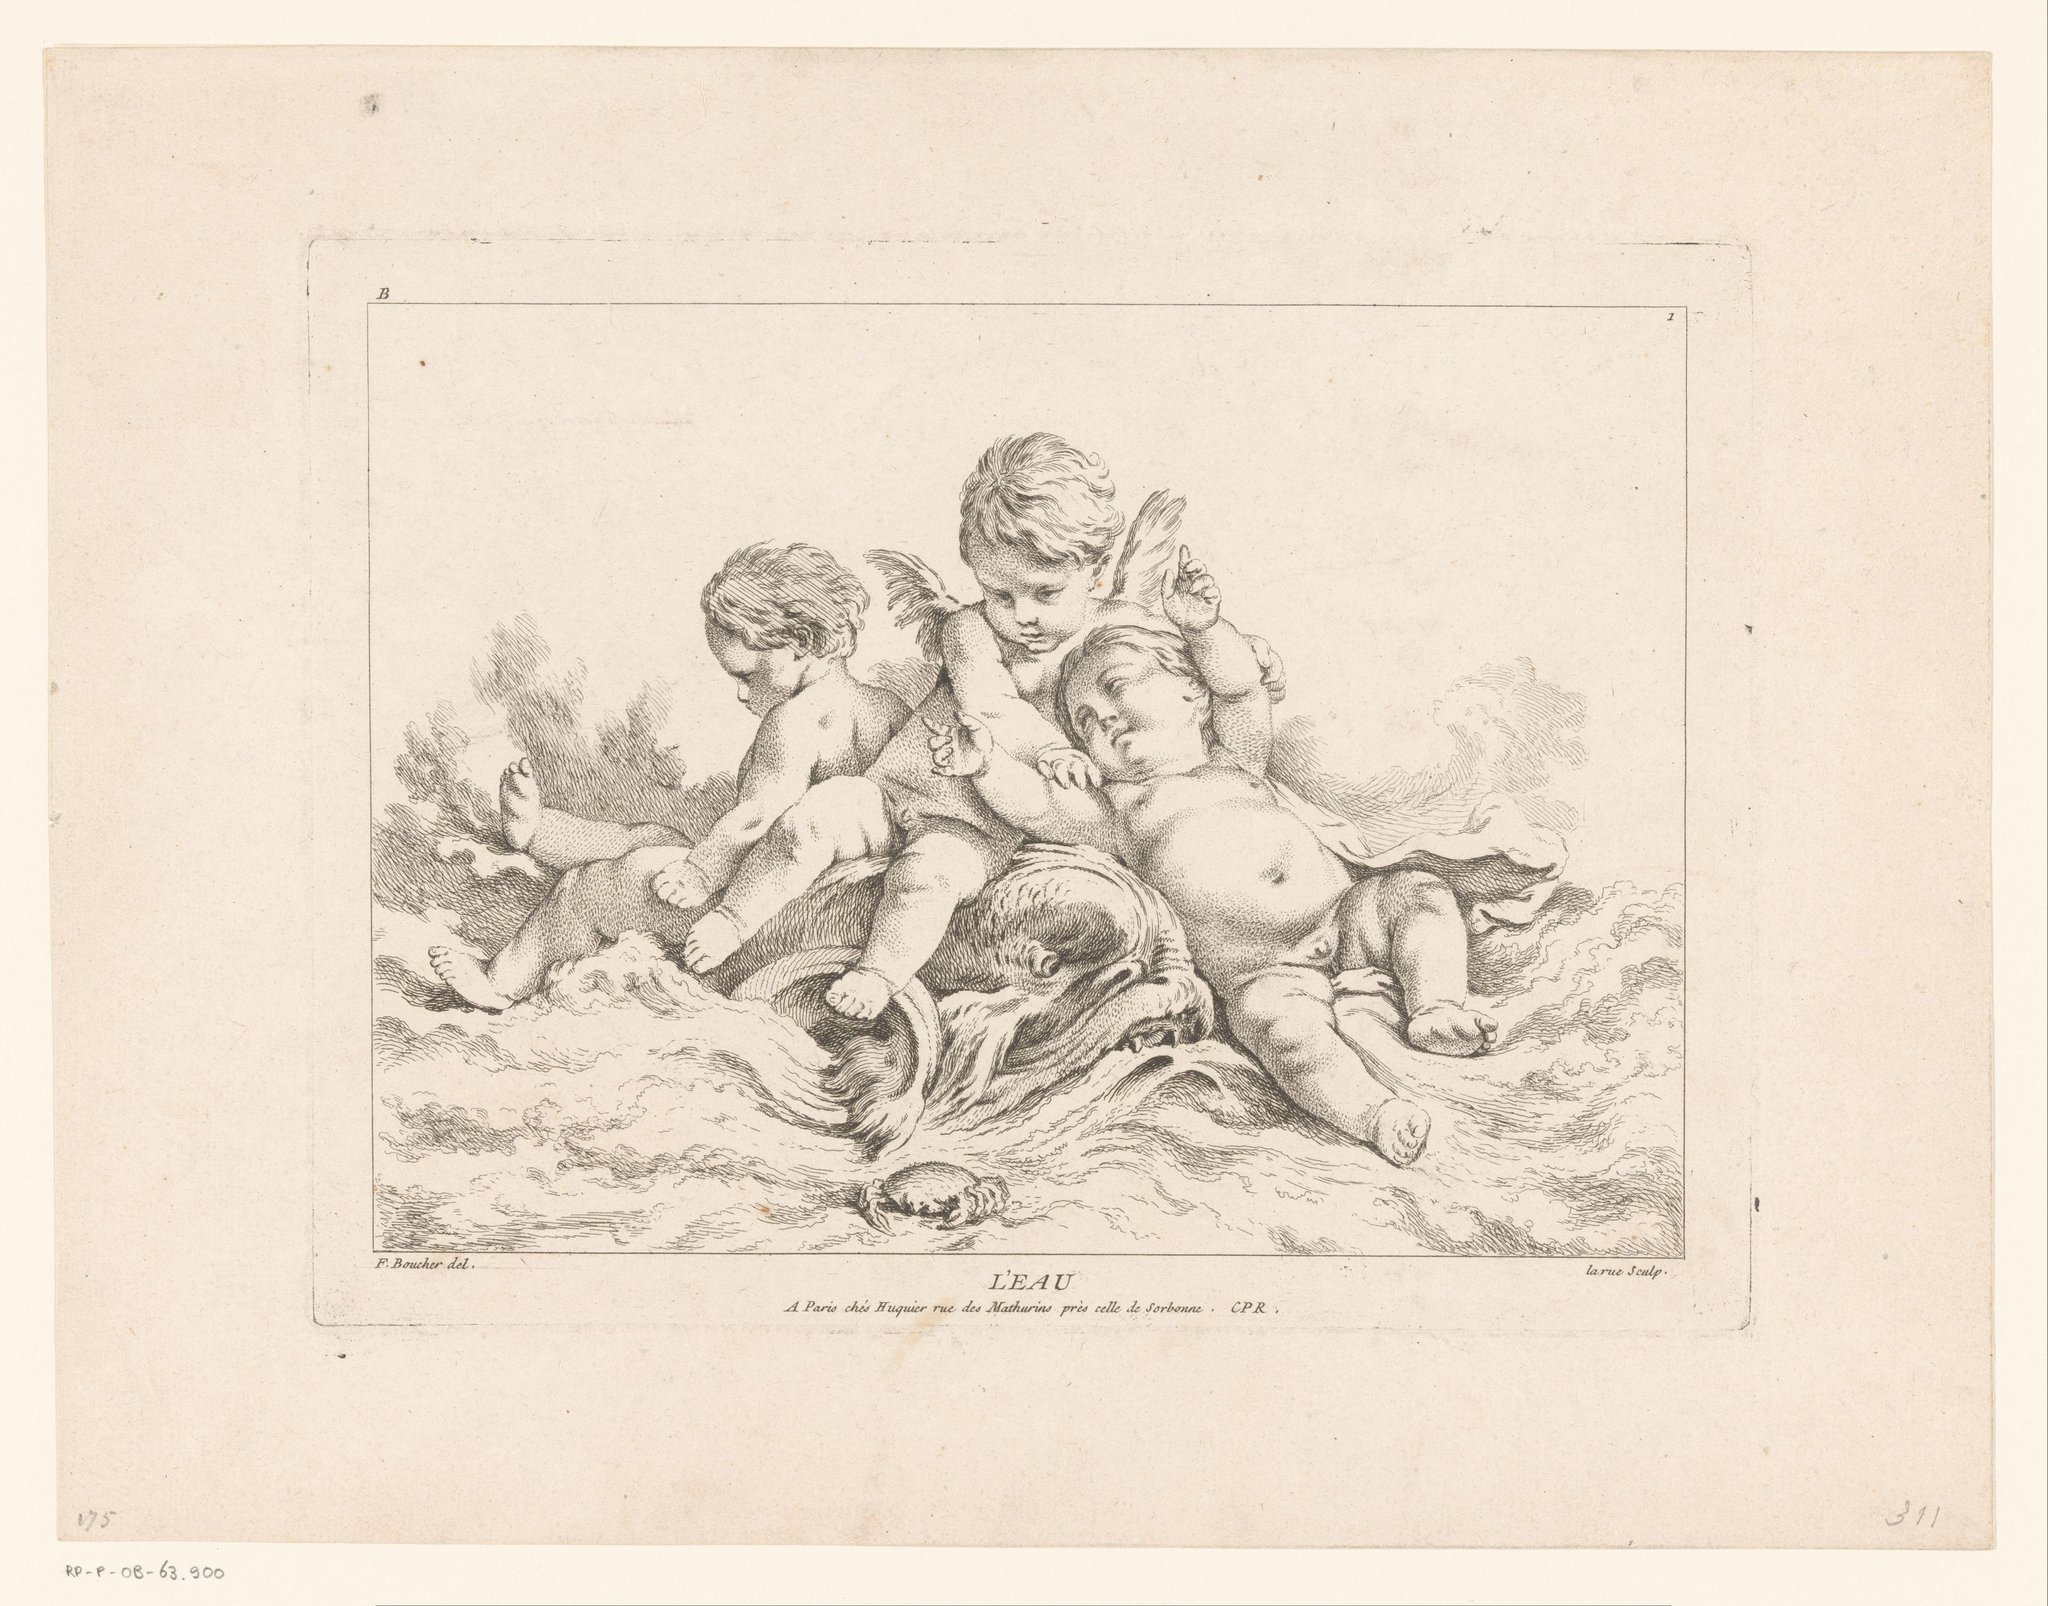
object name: print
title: L'Eau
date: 1741-1765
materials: paper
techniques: etching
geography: france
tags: water (one of the four elements), cupids: 'amores', 'amoretti', 'putti'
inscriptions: collector's mark: Lugt 240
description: Maakt waarschijnlijk deel uit van een vierdelige serie met personificaties van de vier elementen met amors.